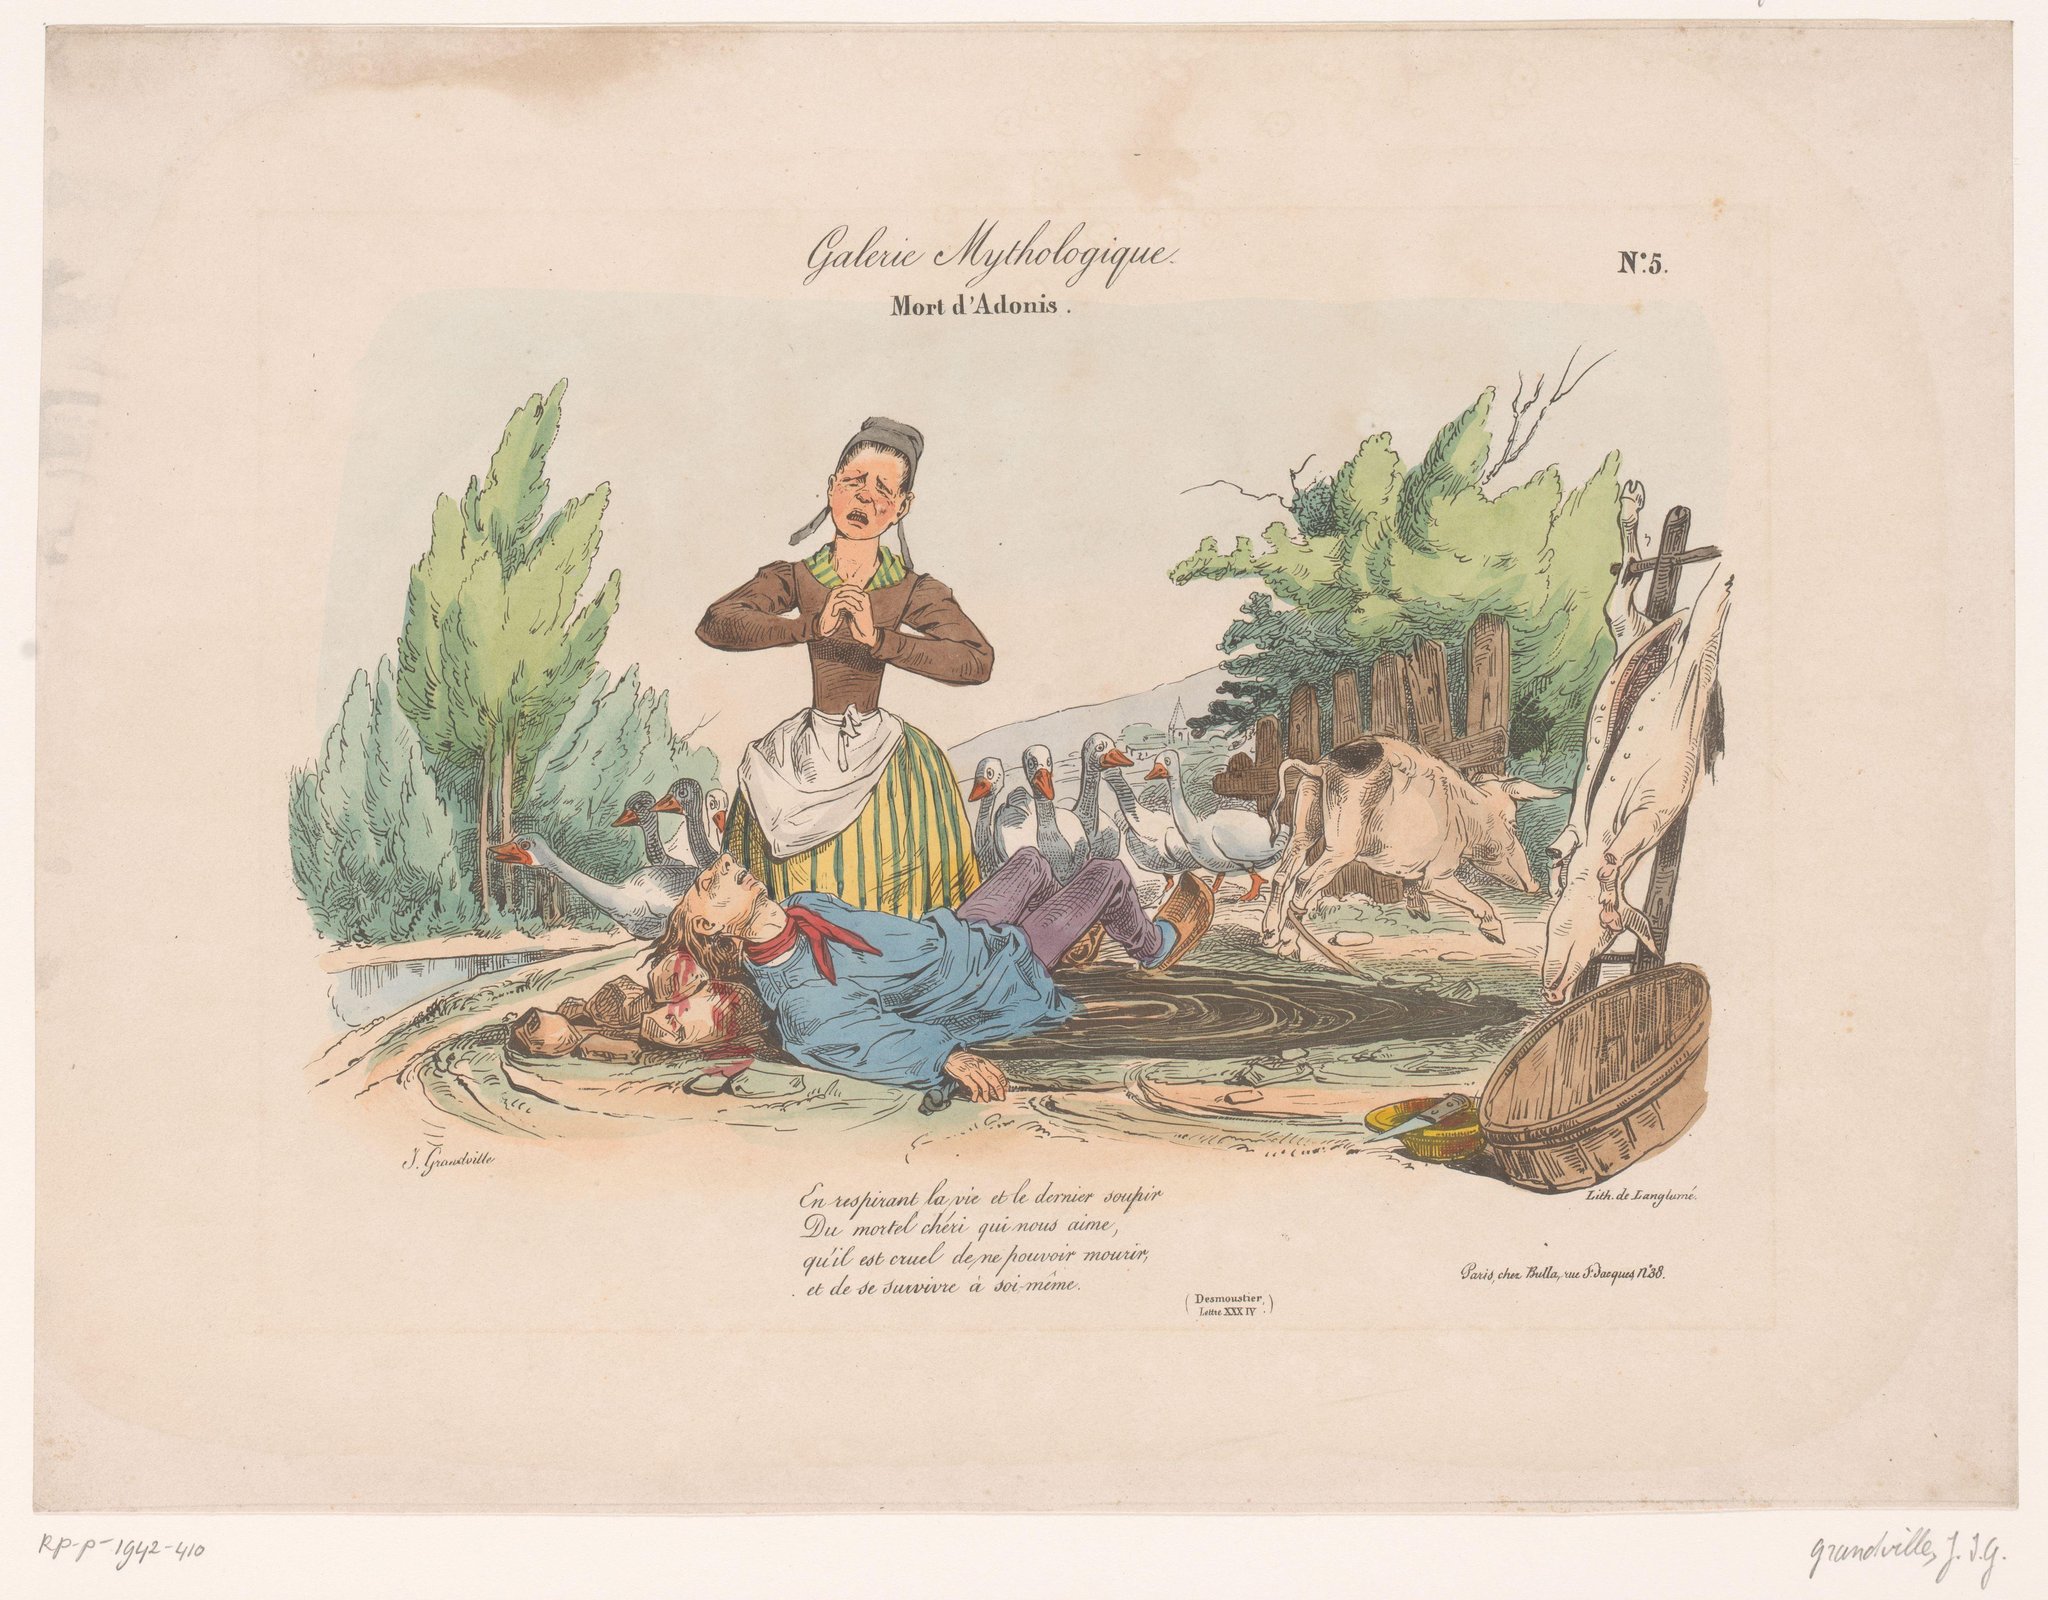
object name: print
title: Mythologische platen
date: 1830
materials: paper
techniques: hand coloring, lithograph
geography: paris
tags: venus mourning adonis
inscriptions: collector's mark: Lugt 2228a, collector's mark: Lugt 2760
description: De tekst onder de afbeelding is afkomstig uit: Desmoustier, C. A. Lettres à Émilie, sur la mythologie. Parijs: Renouard, 1801, dl. 2.